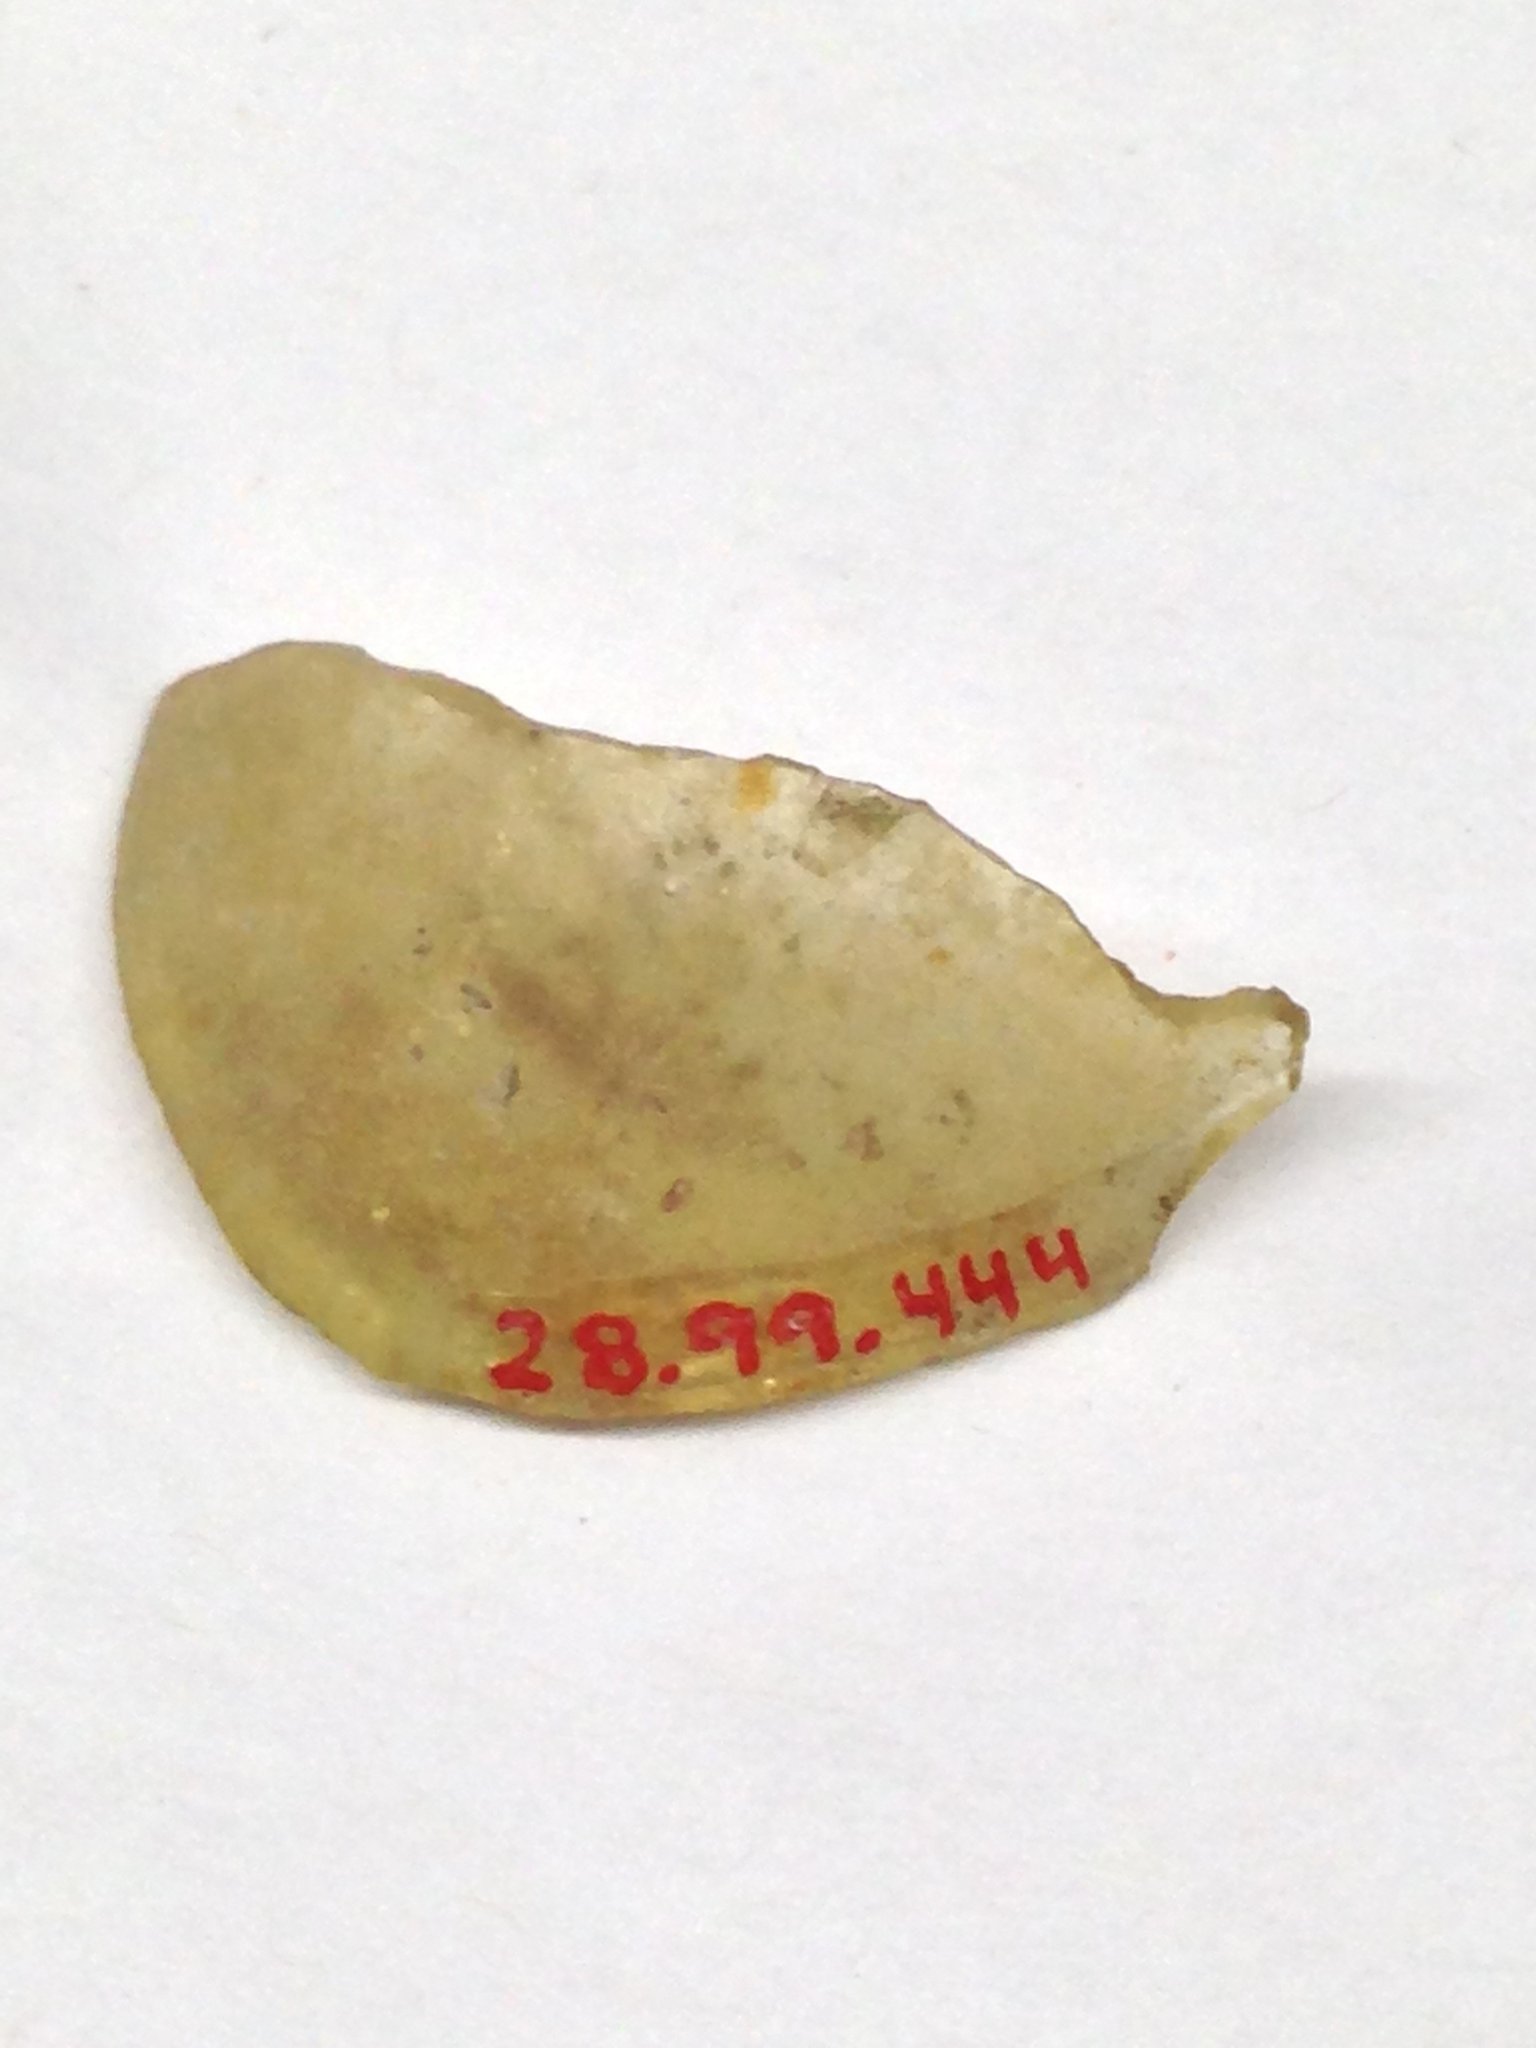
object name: fragment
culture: european or middle eastern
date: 1150-1250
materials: ceramic, glass